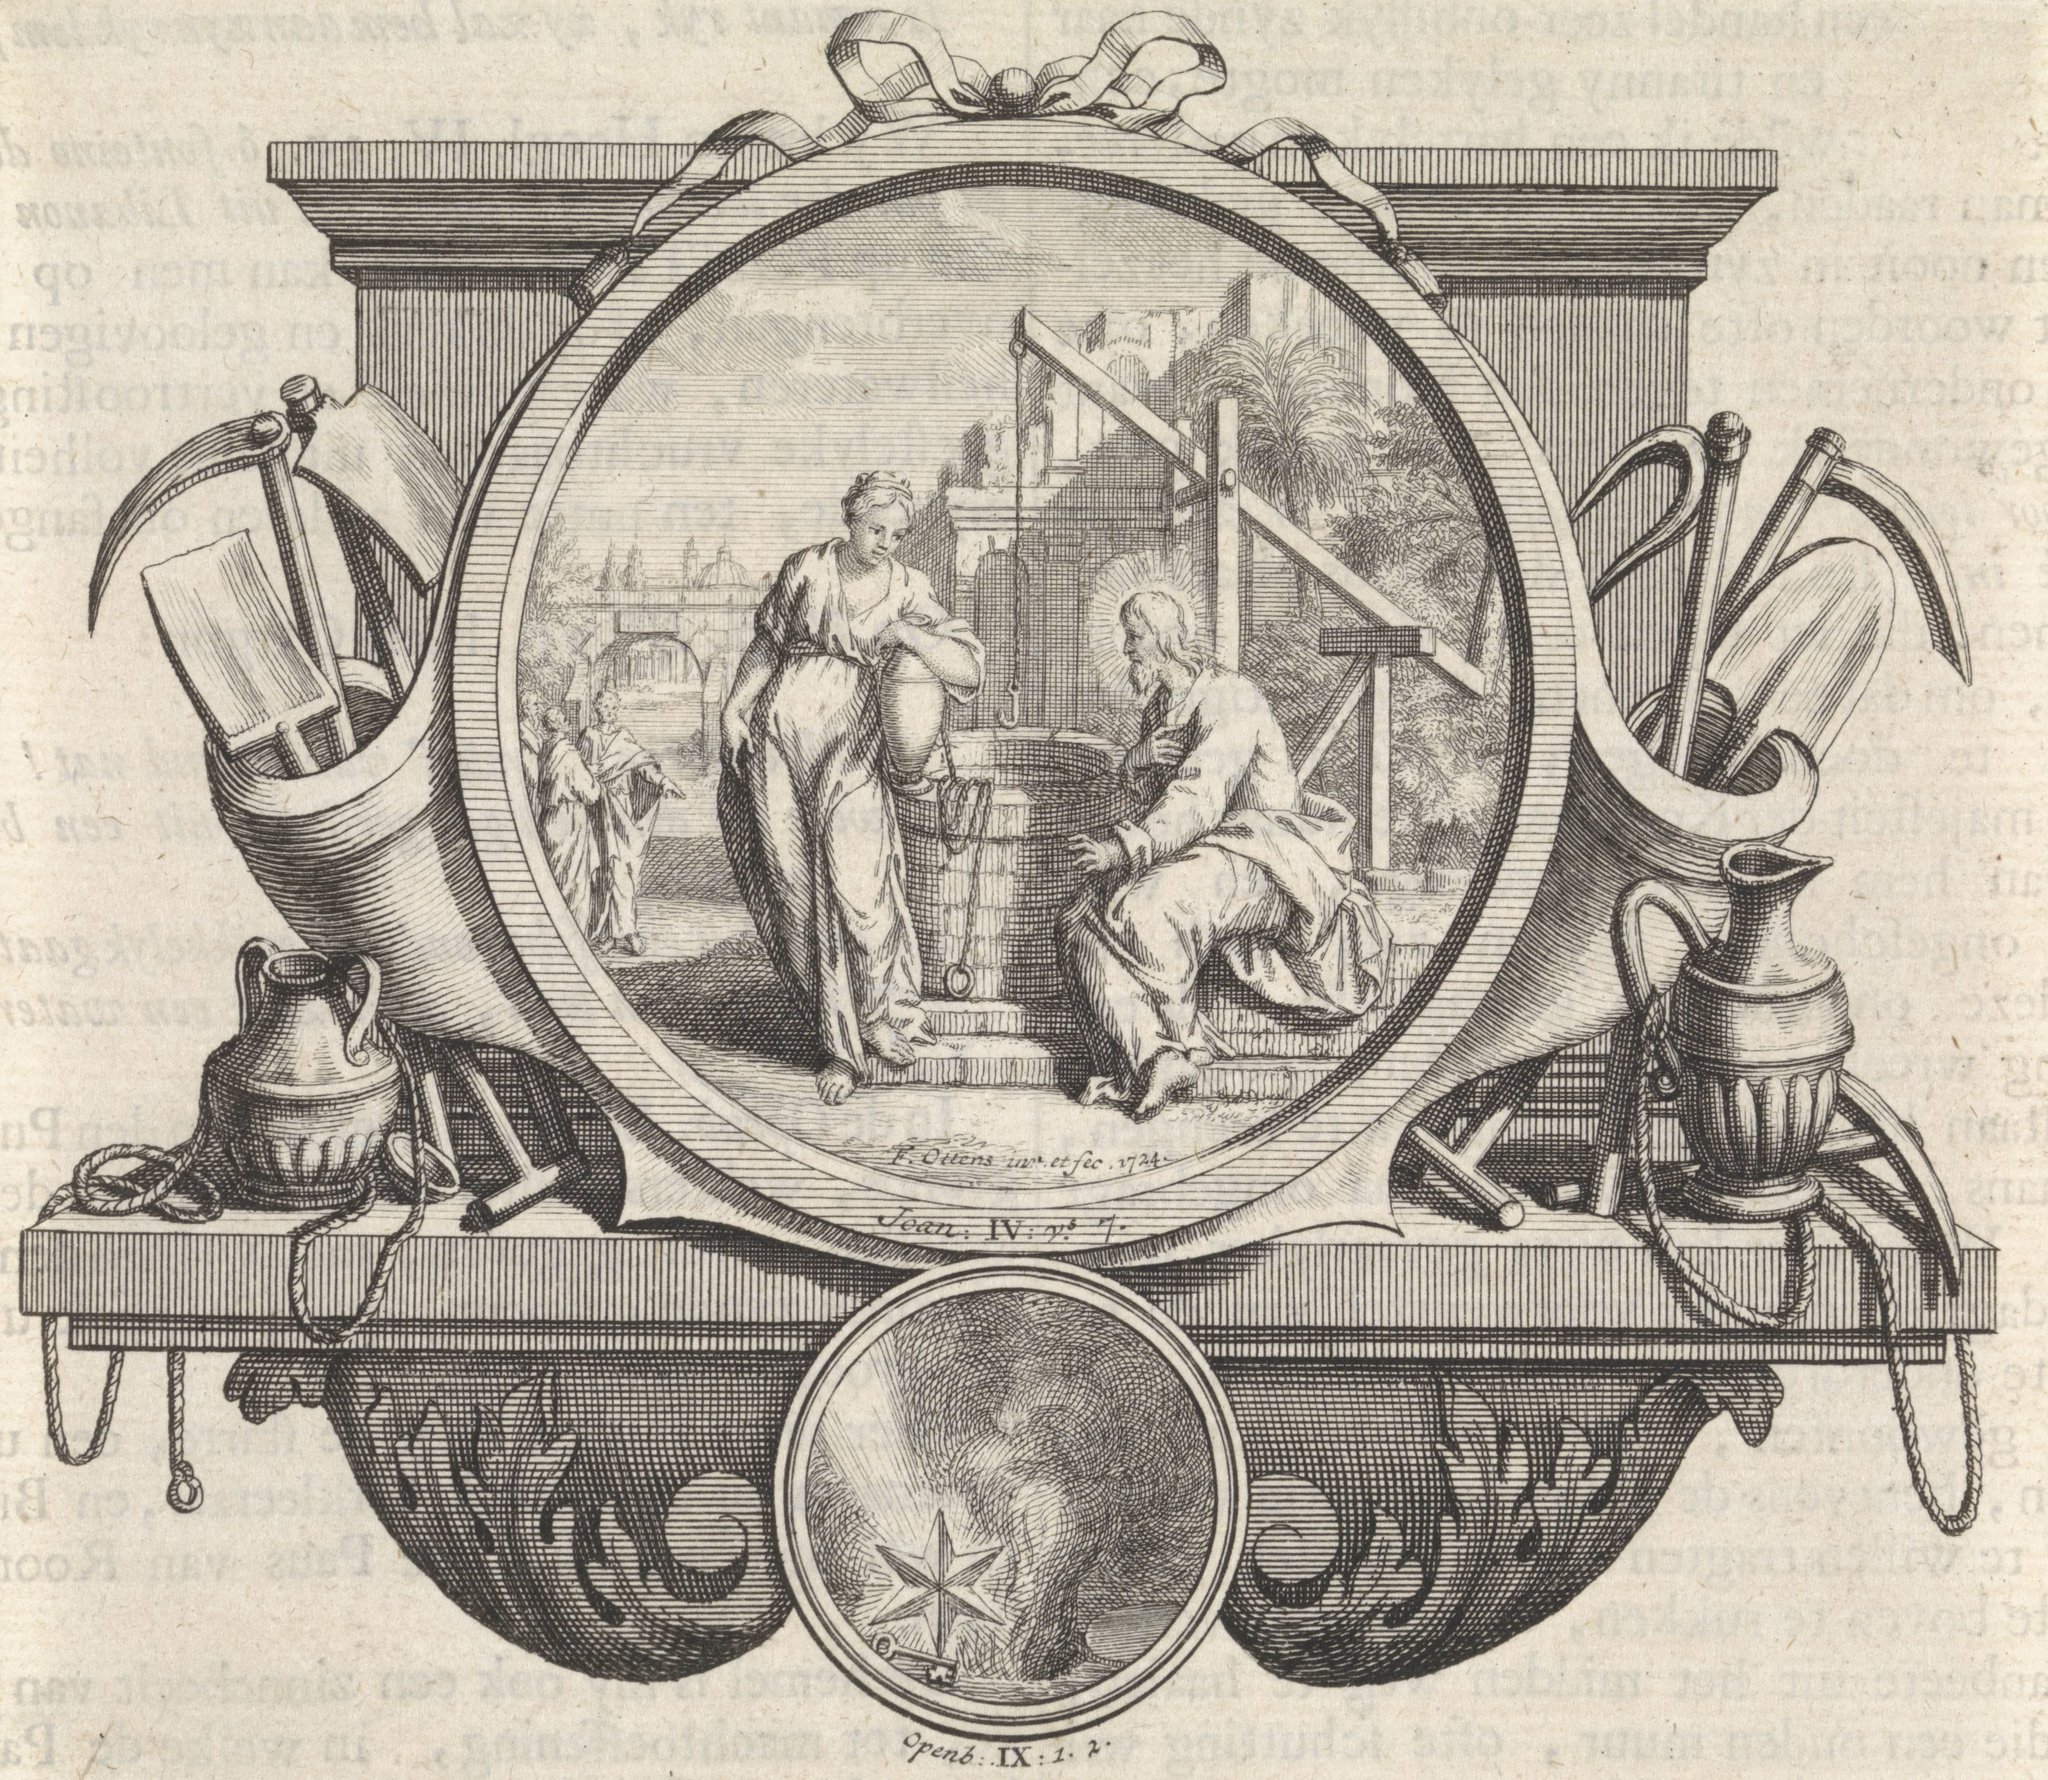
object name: print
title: Christus en de Samaritaanse vrouw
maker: frederik ottens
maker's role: draughtsman, print maker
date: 1724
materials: paper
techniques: engraving, etching, letterpress printing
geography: amsterdam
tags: christ and the woman of samaria: sitting at jacob's well he asks her for a drink from her jug, the fifth of the seven angels sounds the trumpet: the falling star opens up the bottomless pit: smoke comes out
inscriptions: collector's mark: Lugt 2228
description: Christus ontmoet de Samaritaanse vrouw bij de bron. Ronde voorstelling in een omlijsting versiert met gereedschap en kruiken. Onder een kleiner medaillon met een verbeelding van Op. 9, 1-2: een ster die met een sleutel de put naar de onderwereld opent.